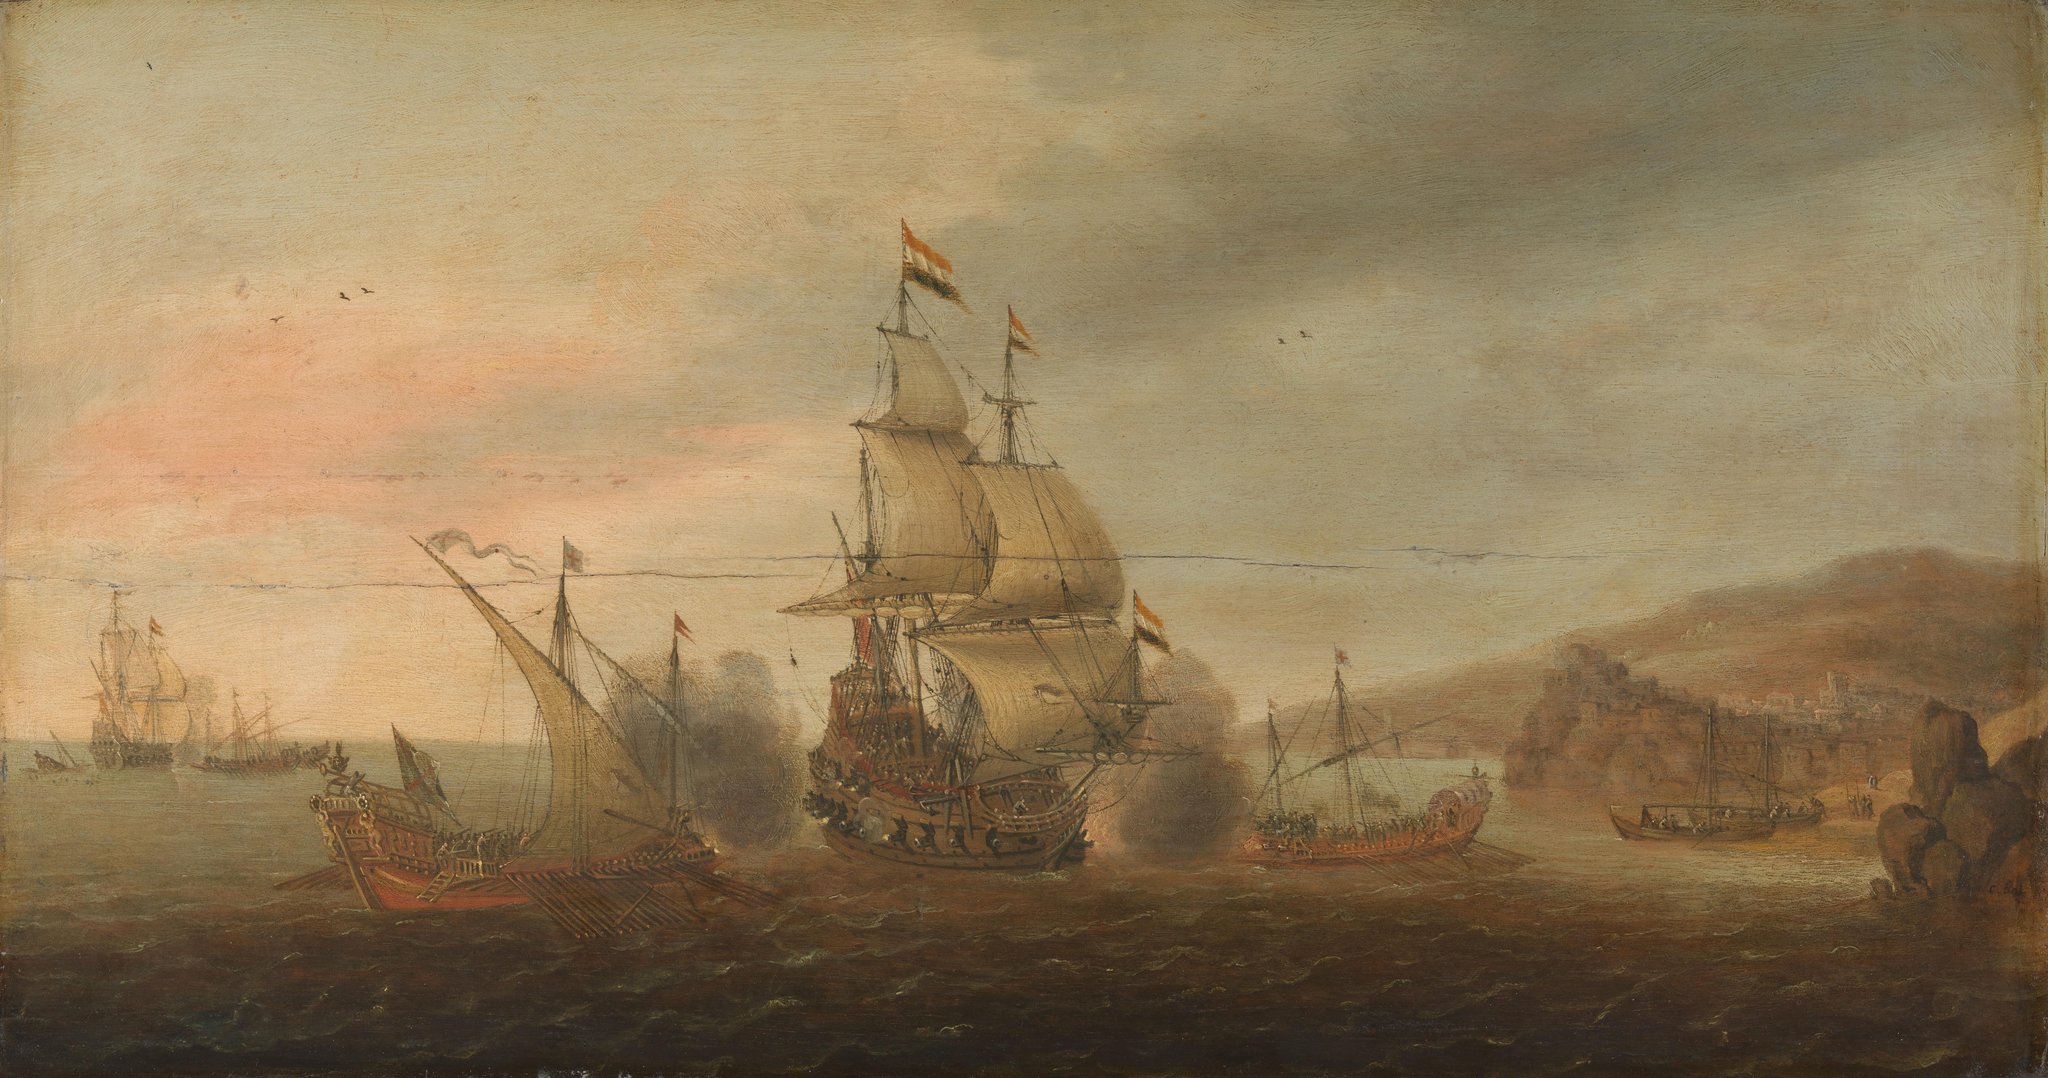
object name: painting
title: Naval Battle between Dutch Men-of-War and Spanish Galleys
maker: cornelis bol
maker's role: print maker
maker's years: 1589-1666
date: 1633-1650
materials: oil, panel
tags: battle (+ sailing-ships), battle (+ oared ships, e.g.: galley), low countries, spain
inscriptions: signature, bottom right on a rock: ‘C. Bol’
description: Zeeslag tussen Hollandse oorlogsschepen en Spaanse galeien (voor de Vlaamse kust op 3 oktober 1602?).